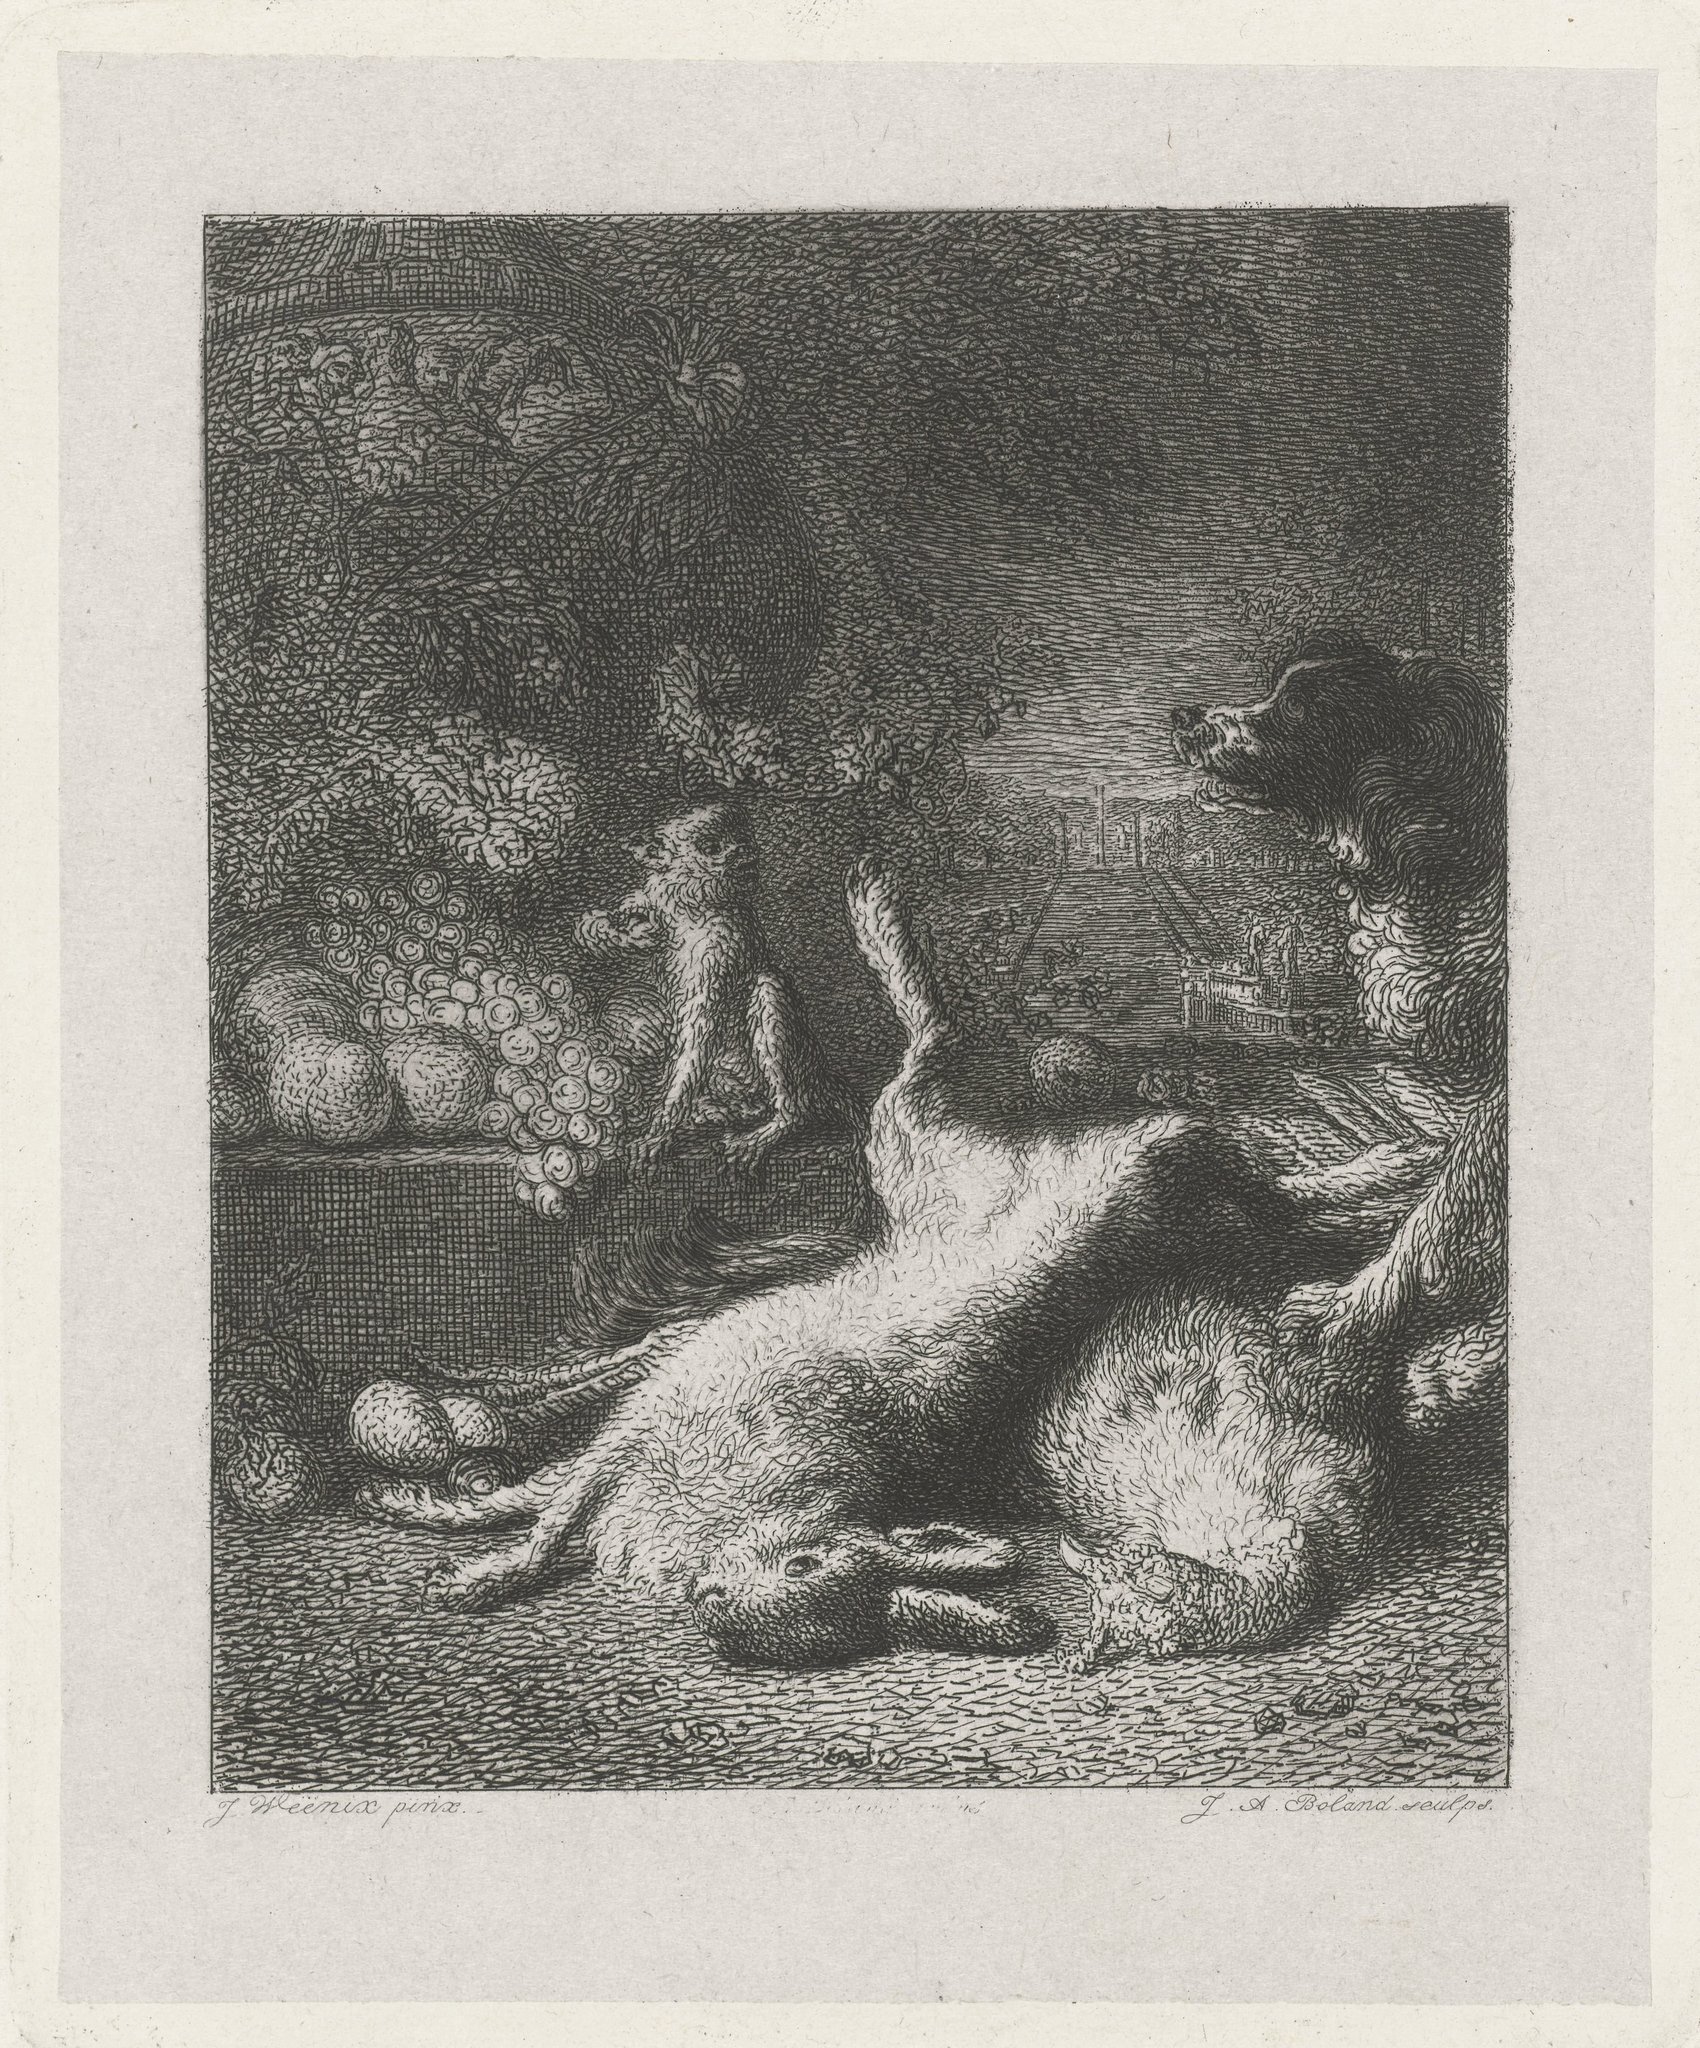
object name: print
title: Een aap en een hond bij dood wild en vruchten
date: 1875-1876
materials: paper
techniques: etching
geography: amsterdam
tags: spoils of the hunt, game, venison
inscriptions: collector's mark: Lugt 2228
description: Reproductie van een schilderij uit de collectie van het Rijksmuseum Amsterdam, SK-A-463. Prent afkomstig uit: Brink, J. ten (et al.). Het Rijksmuseum te Amsterdam: [25] etsen van J.A. Boland. Haarlem: J.M. Schalekamp, [1875-1876] (13 A 20).